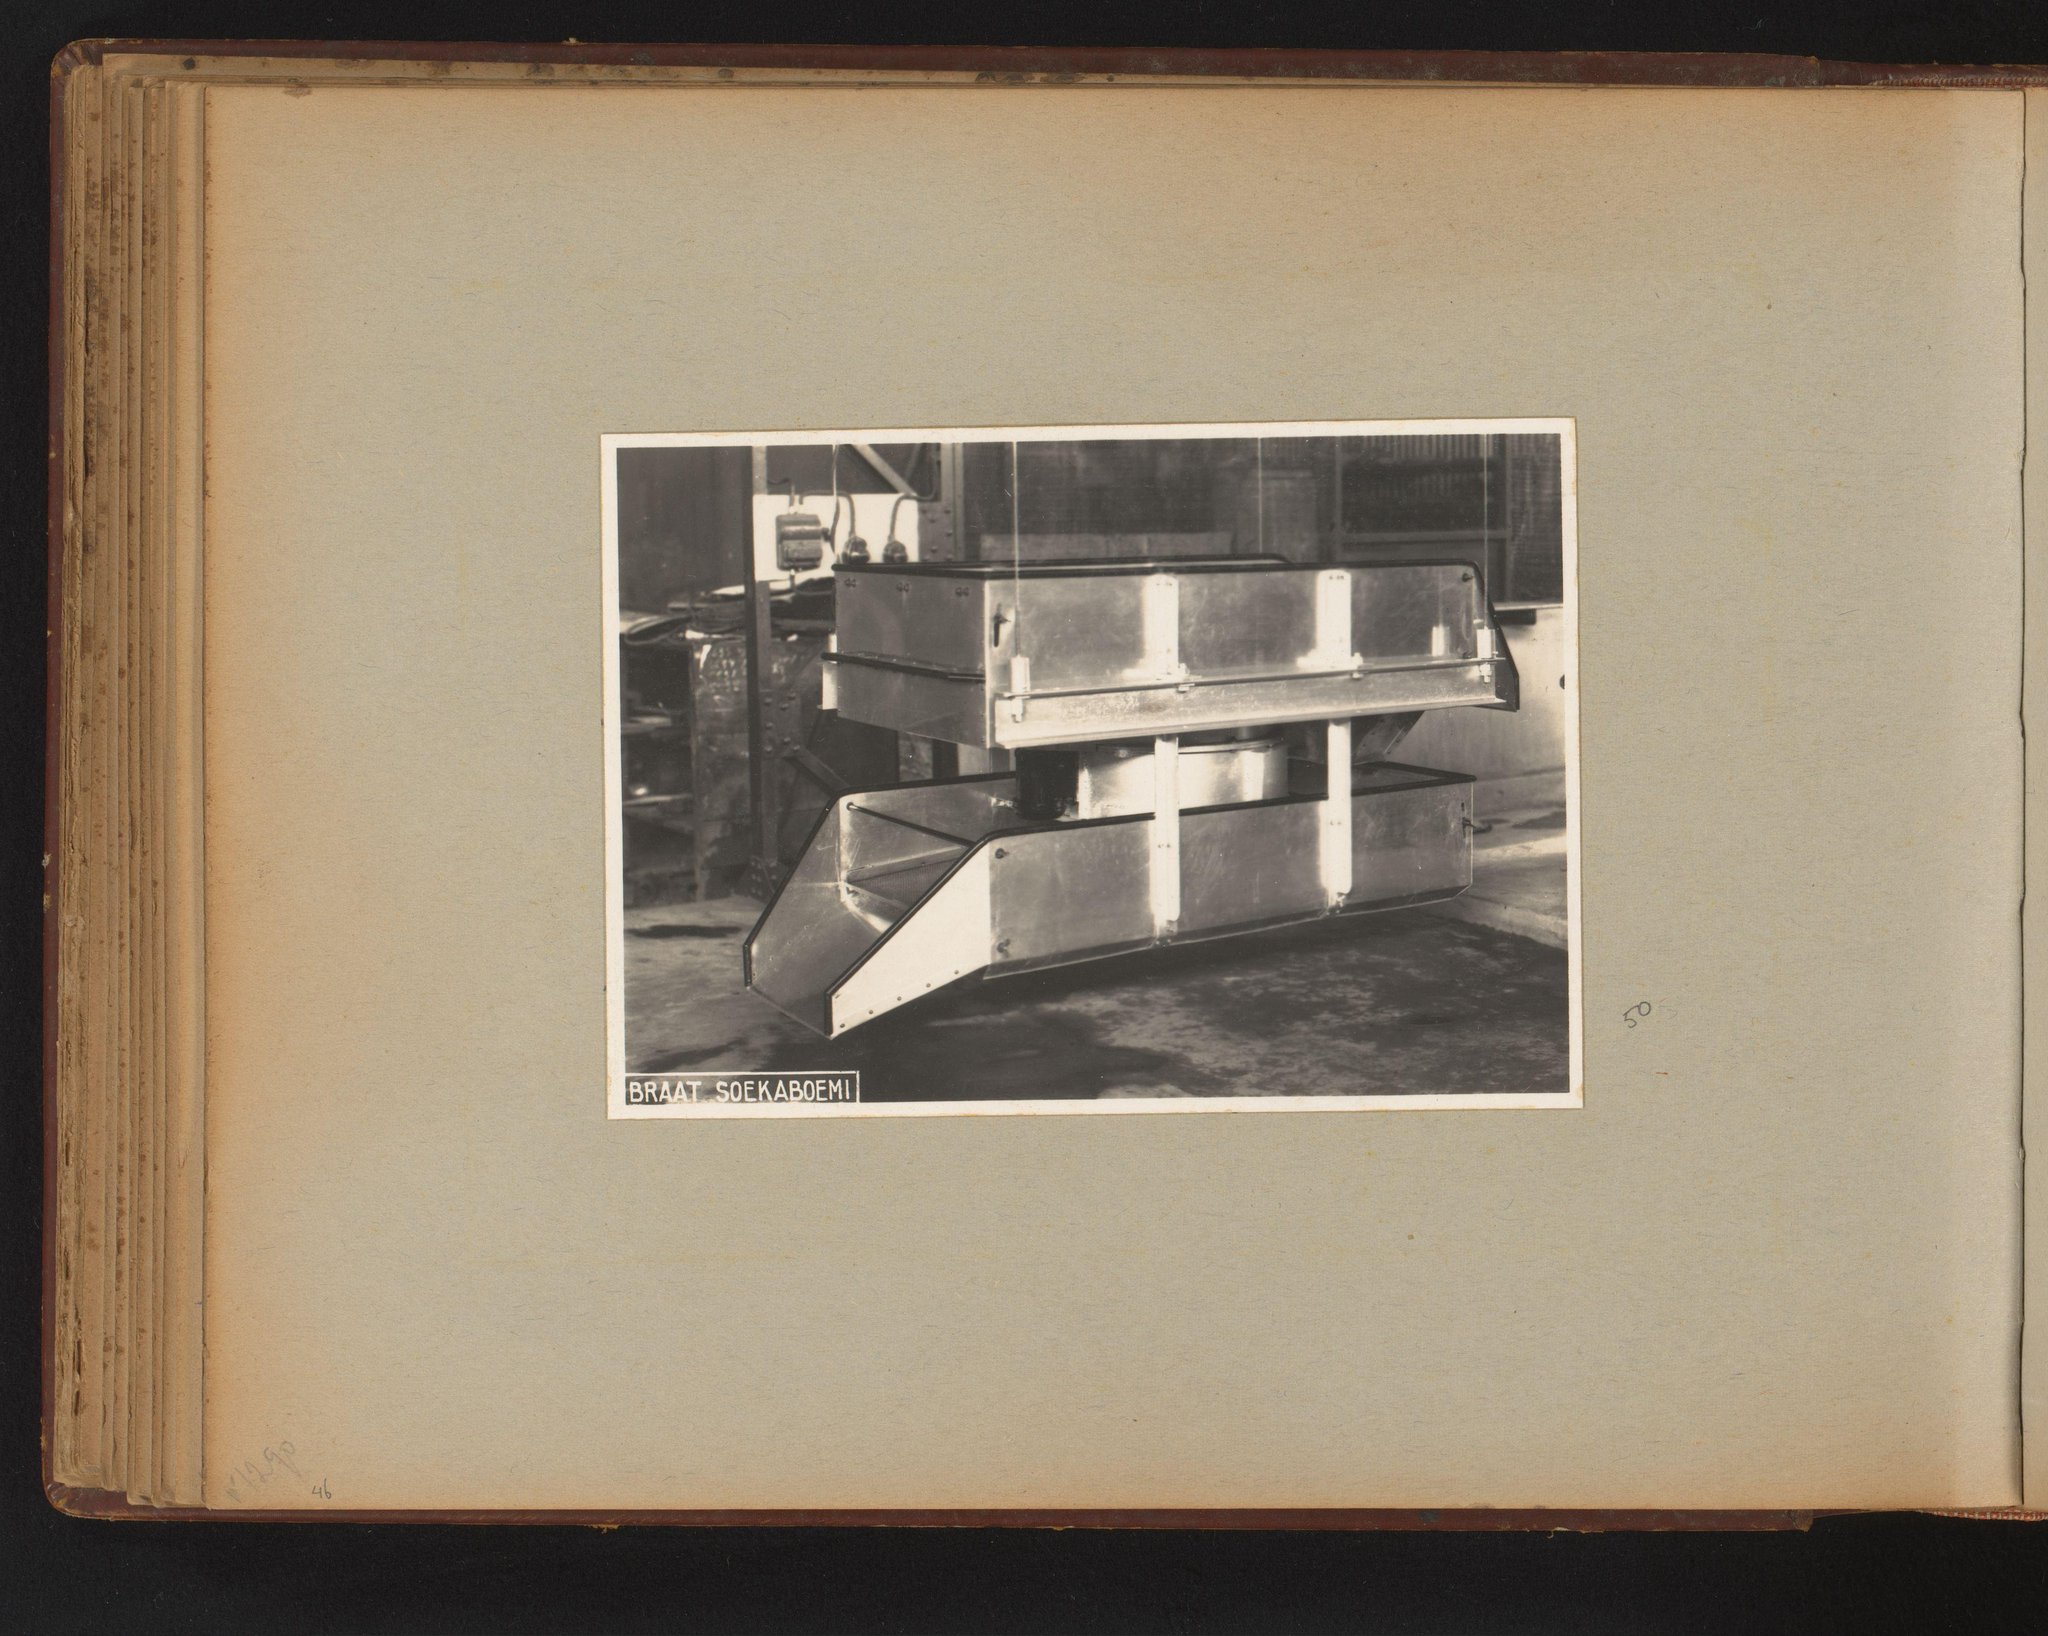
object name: photograph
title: Machineonderdelen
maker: Anonymous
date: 1931-1937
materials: cardboard, photographic support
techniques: gelatin silver print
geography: soekaboemi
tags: factory-interior, machine shop, machines; parts of machines; tools and appliances, java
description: Albumblad met een foto van de fabricage van onderdelen voor een machine. Onderdeel van een fotoalbum met foto's van machines en constructies van de N.V. Machinefabriek Braat te Soerabaja, Soekaboemi en Tegal uit de periode 1931-1937.